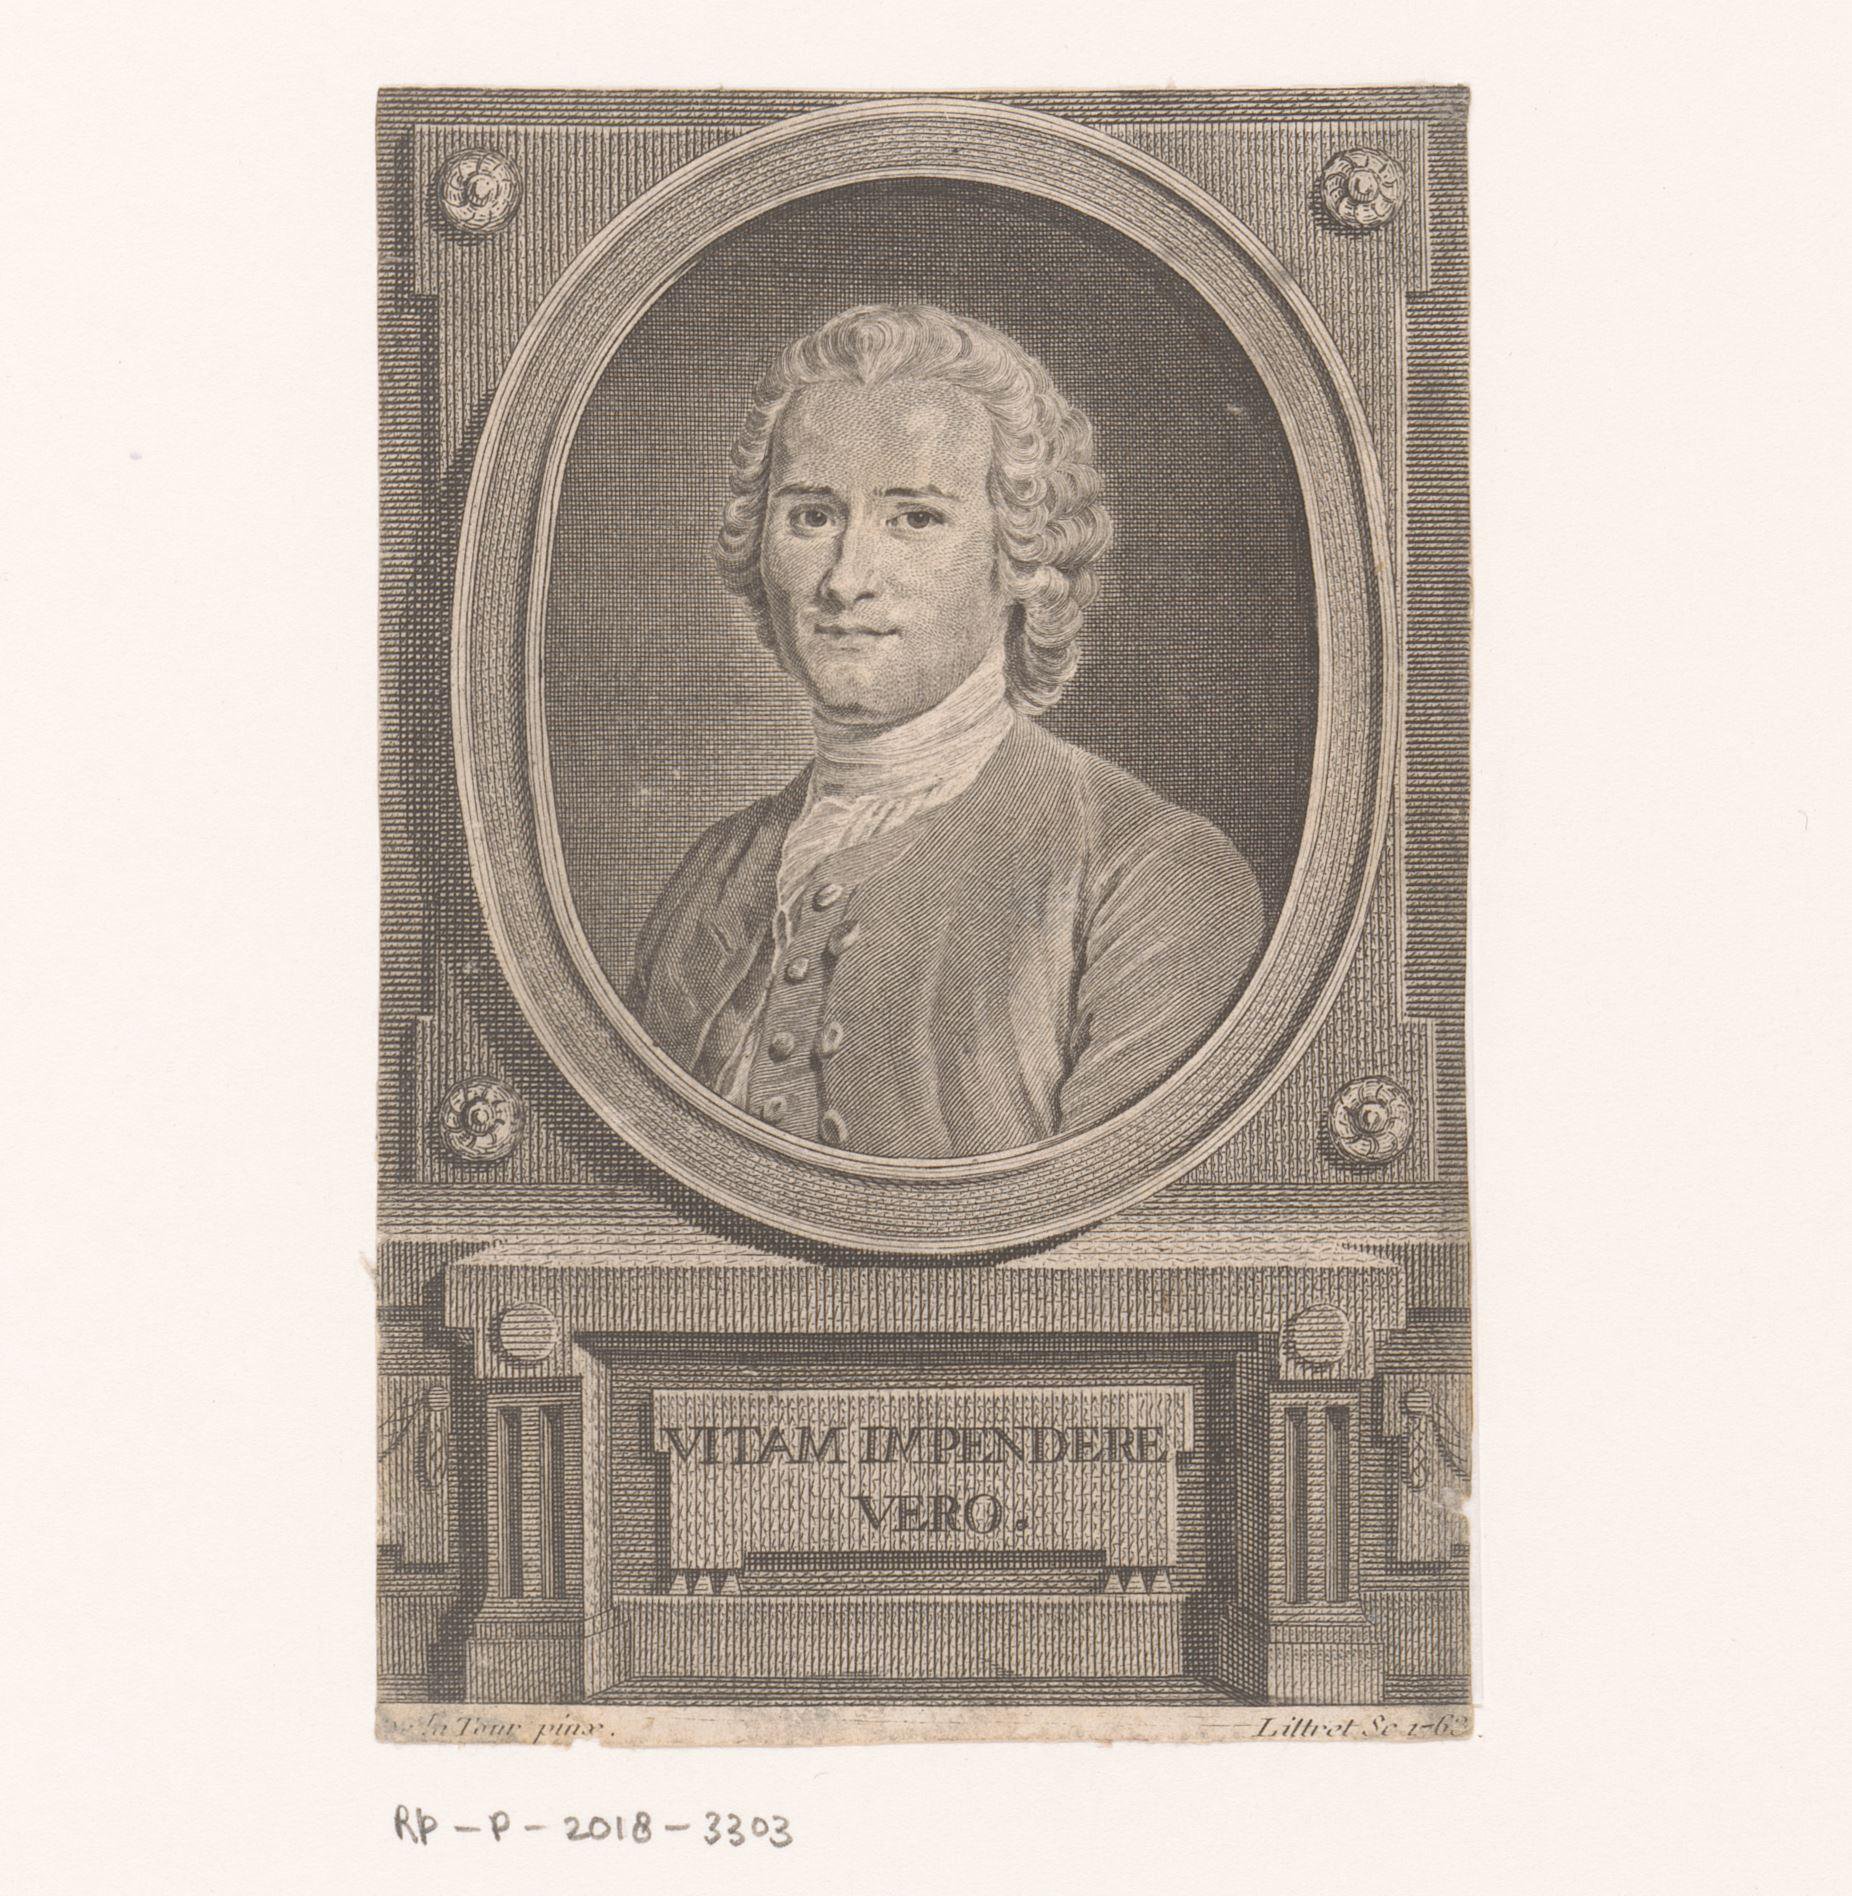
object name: print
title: Portret van Jean-Jacques Rousseau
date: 1763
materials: paper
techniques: engraving, etching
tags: scholar, philosopher, historical persons, portrait of a writer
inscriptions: collector's mark: Lugt 2760, collector's mark: Lugt 2228